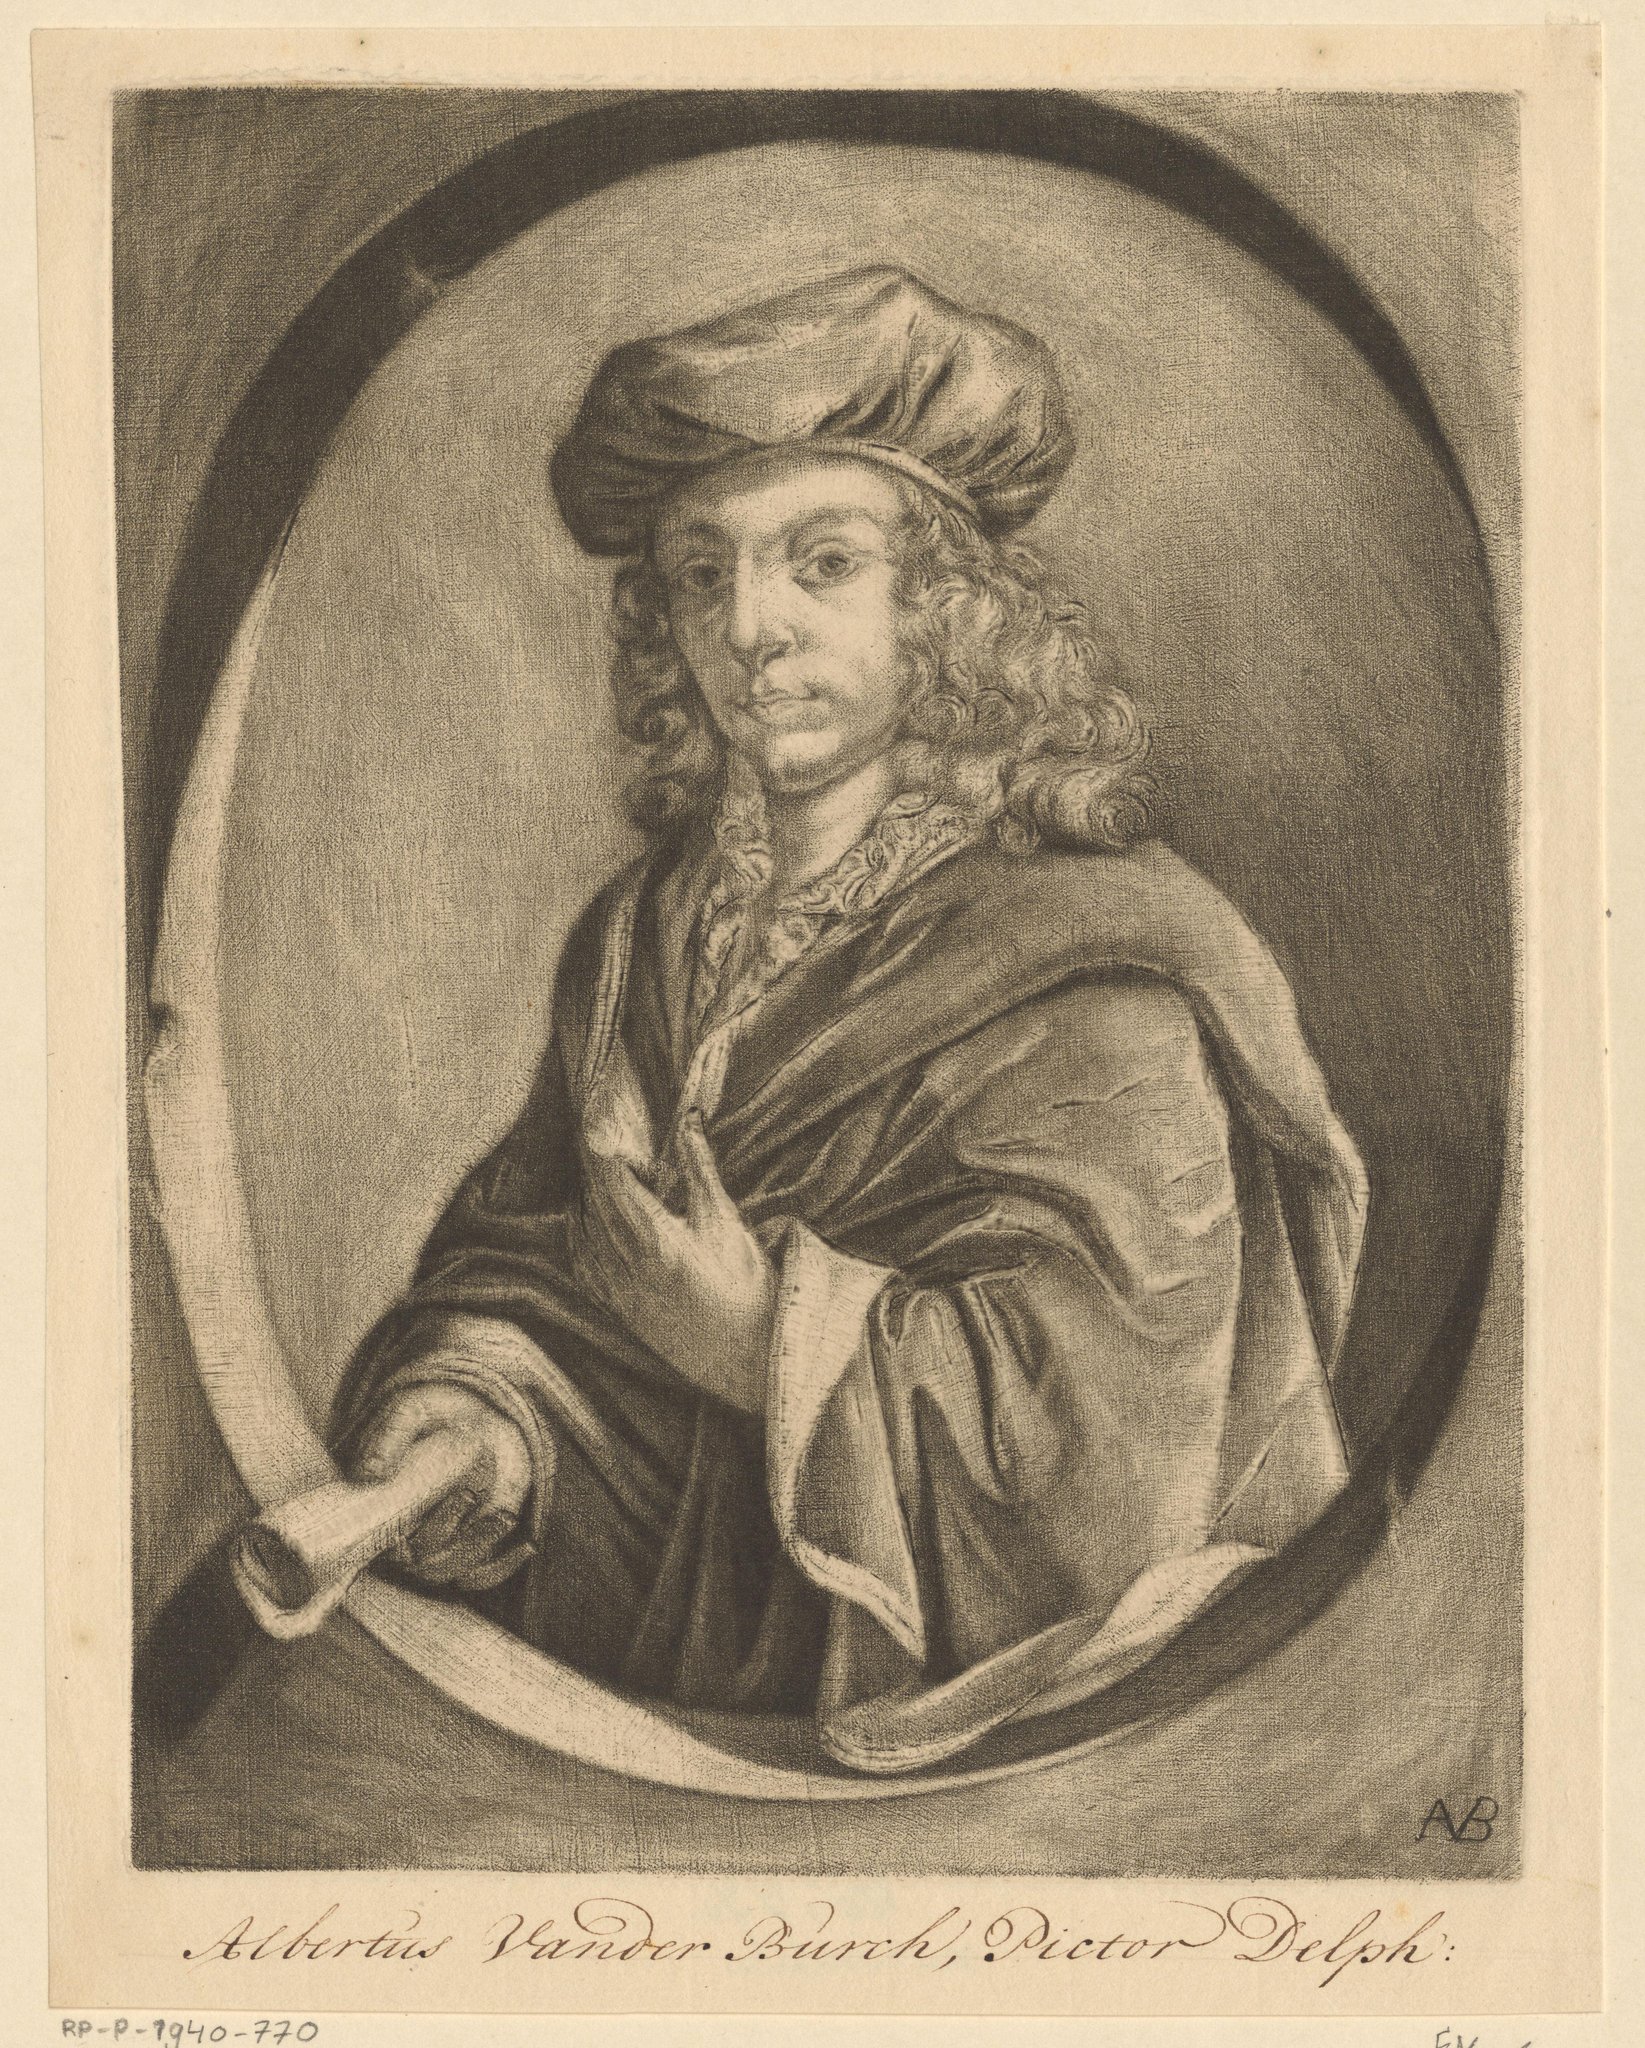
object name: print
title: Zelfportret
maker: albertus van der burch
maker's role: print maker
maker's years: 1672-1729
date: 1687-1729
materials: paper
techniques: mezzotint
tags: albertus van der burch, historical persons, portrait, self-portrait of artist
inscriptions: inscription: ‘Albertus vander Burch, Pictor Delph:’